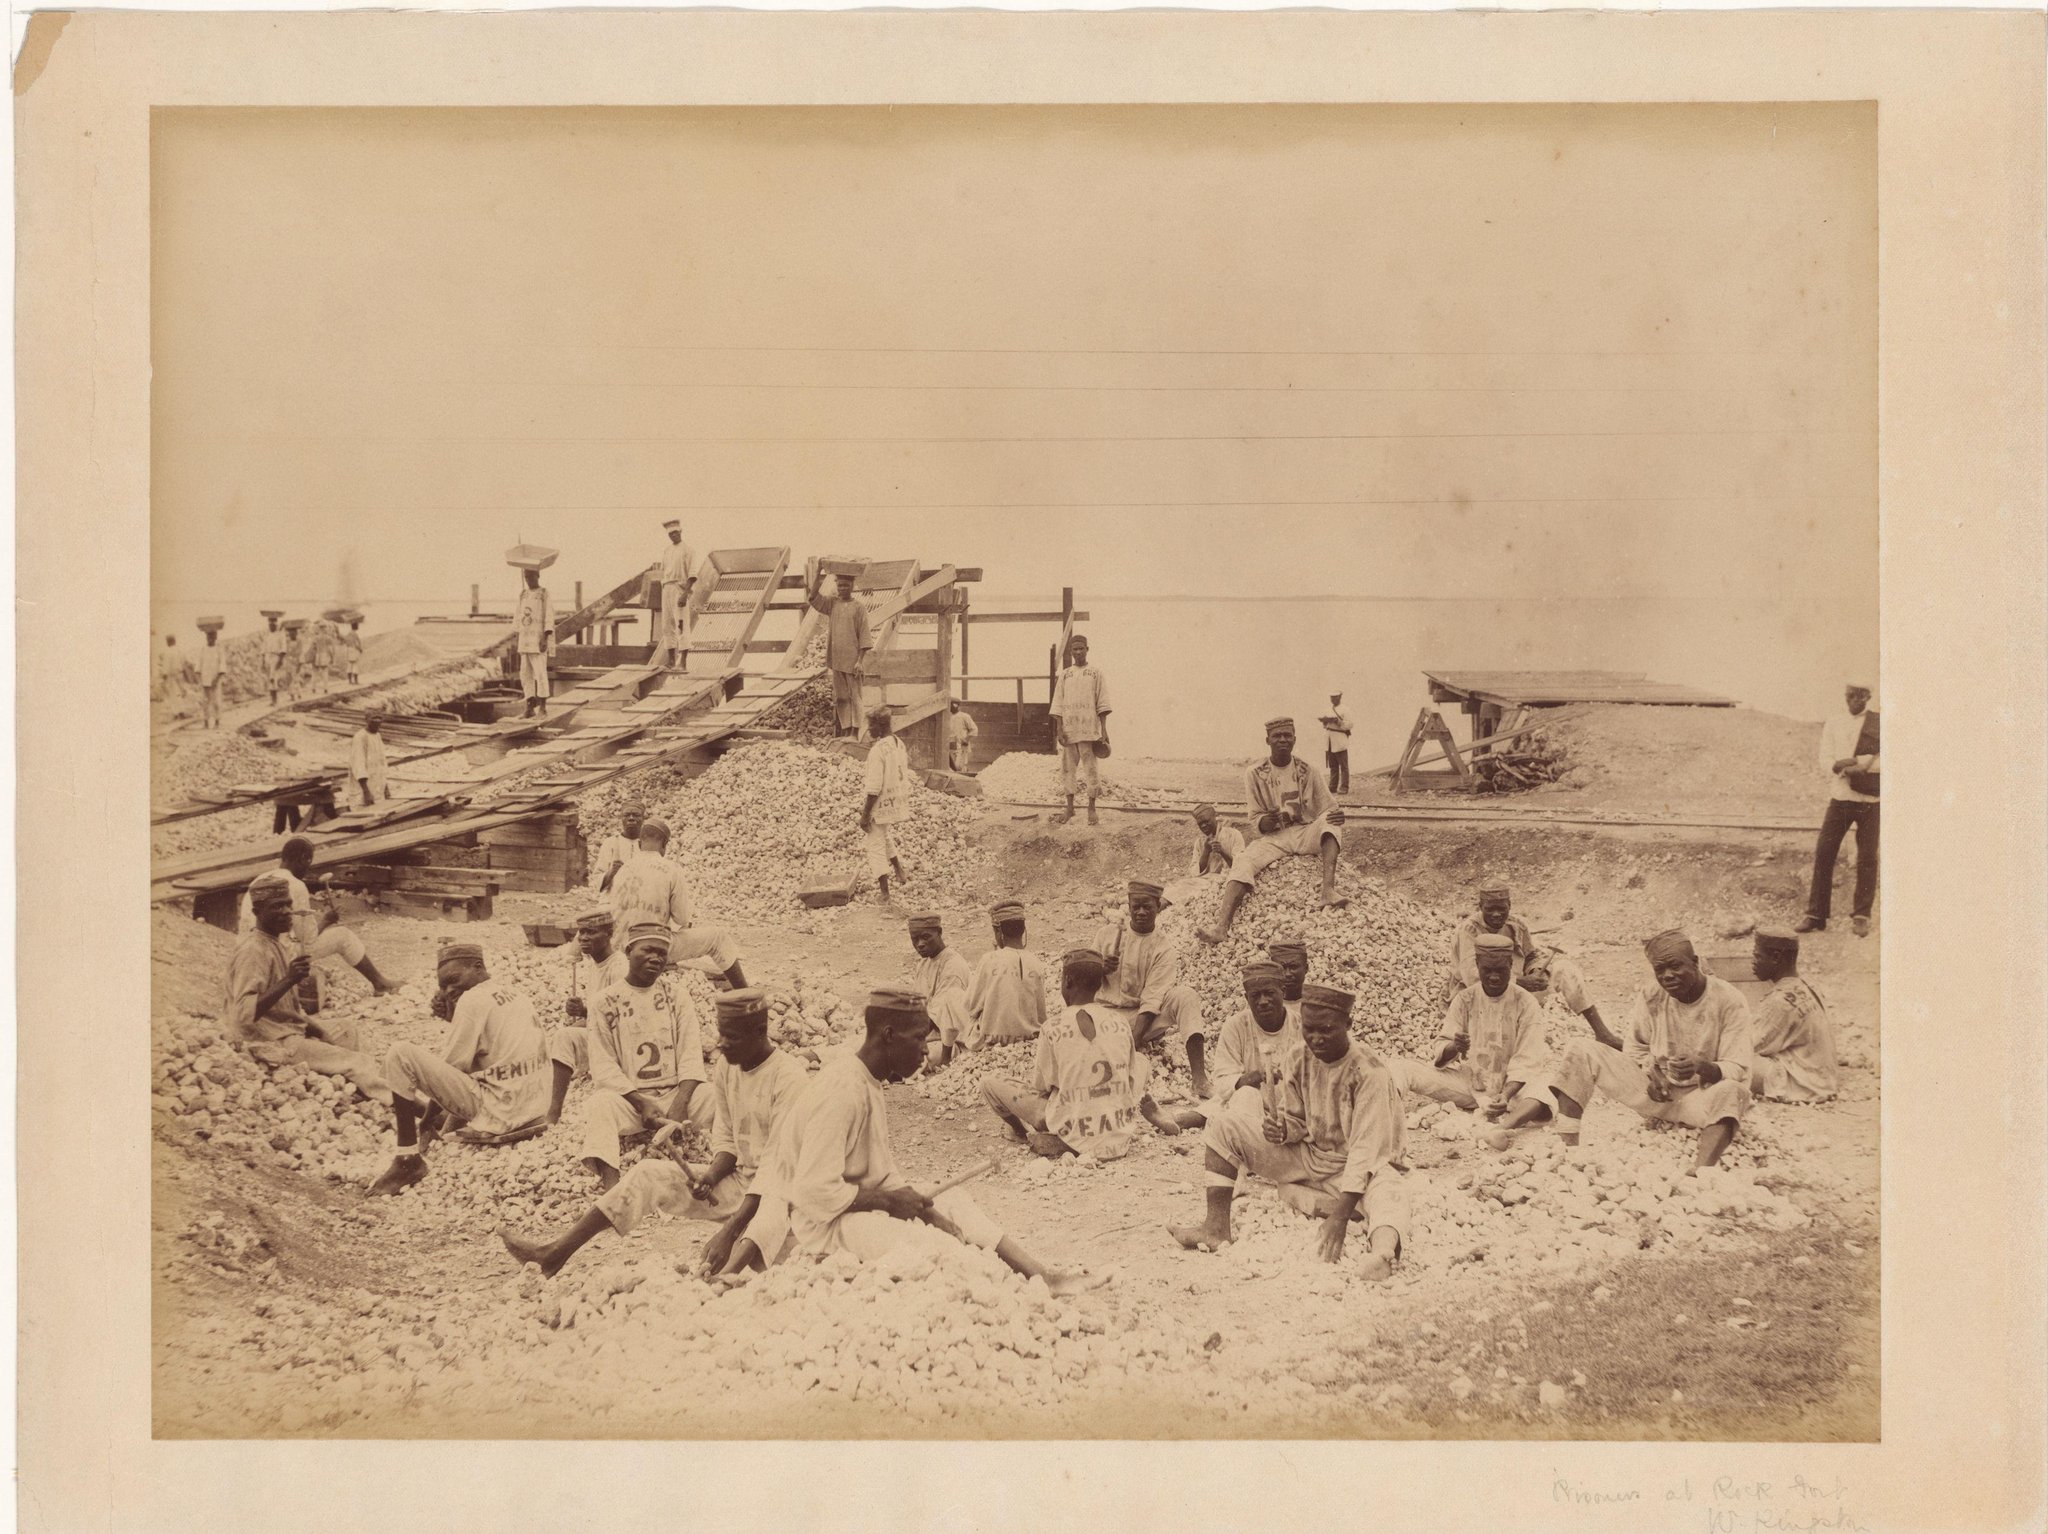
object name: photograph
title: Gevangenen bij Rockfort, Kingston, Jamaica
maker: Anonymous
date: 1860-1890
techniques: albumen print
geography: jamaica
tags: rockfort